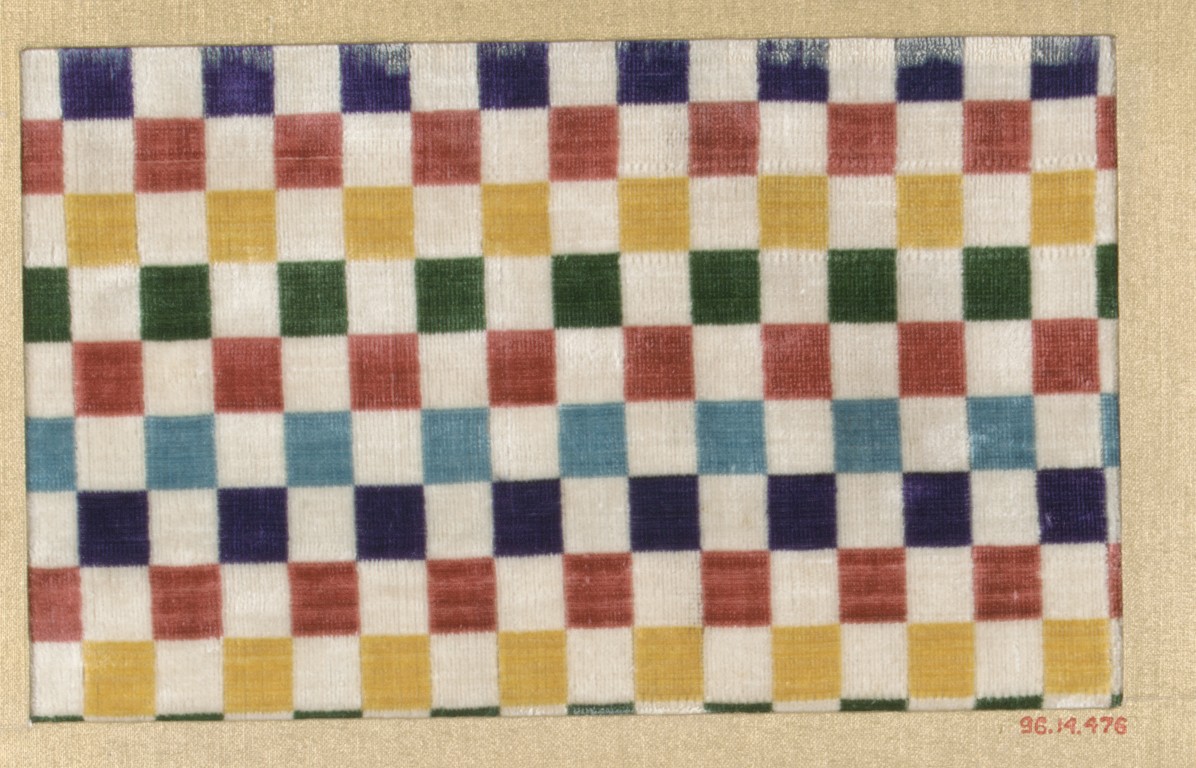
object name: piece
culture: japanese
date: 1701-1900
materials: silk